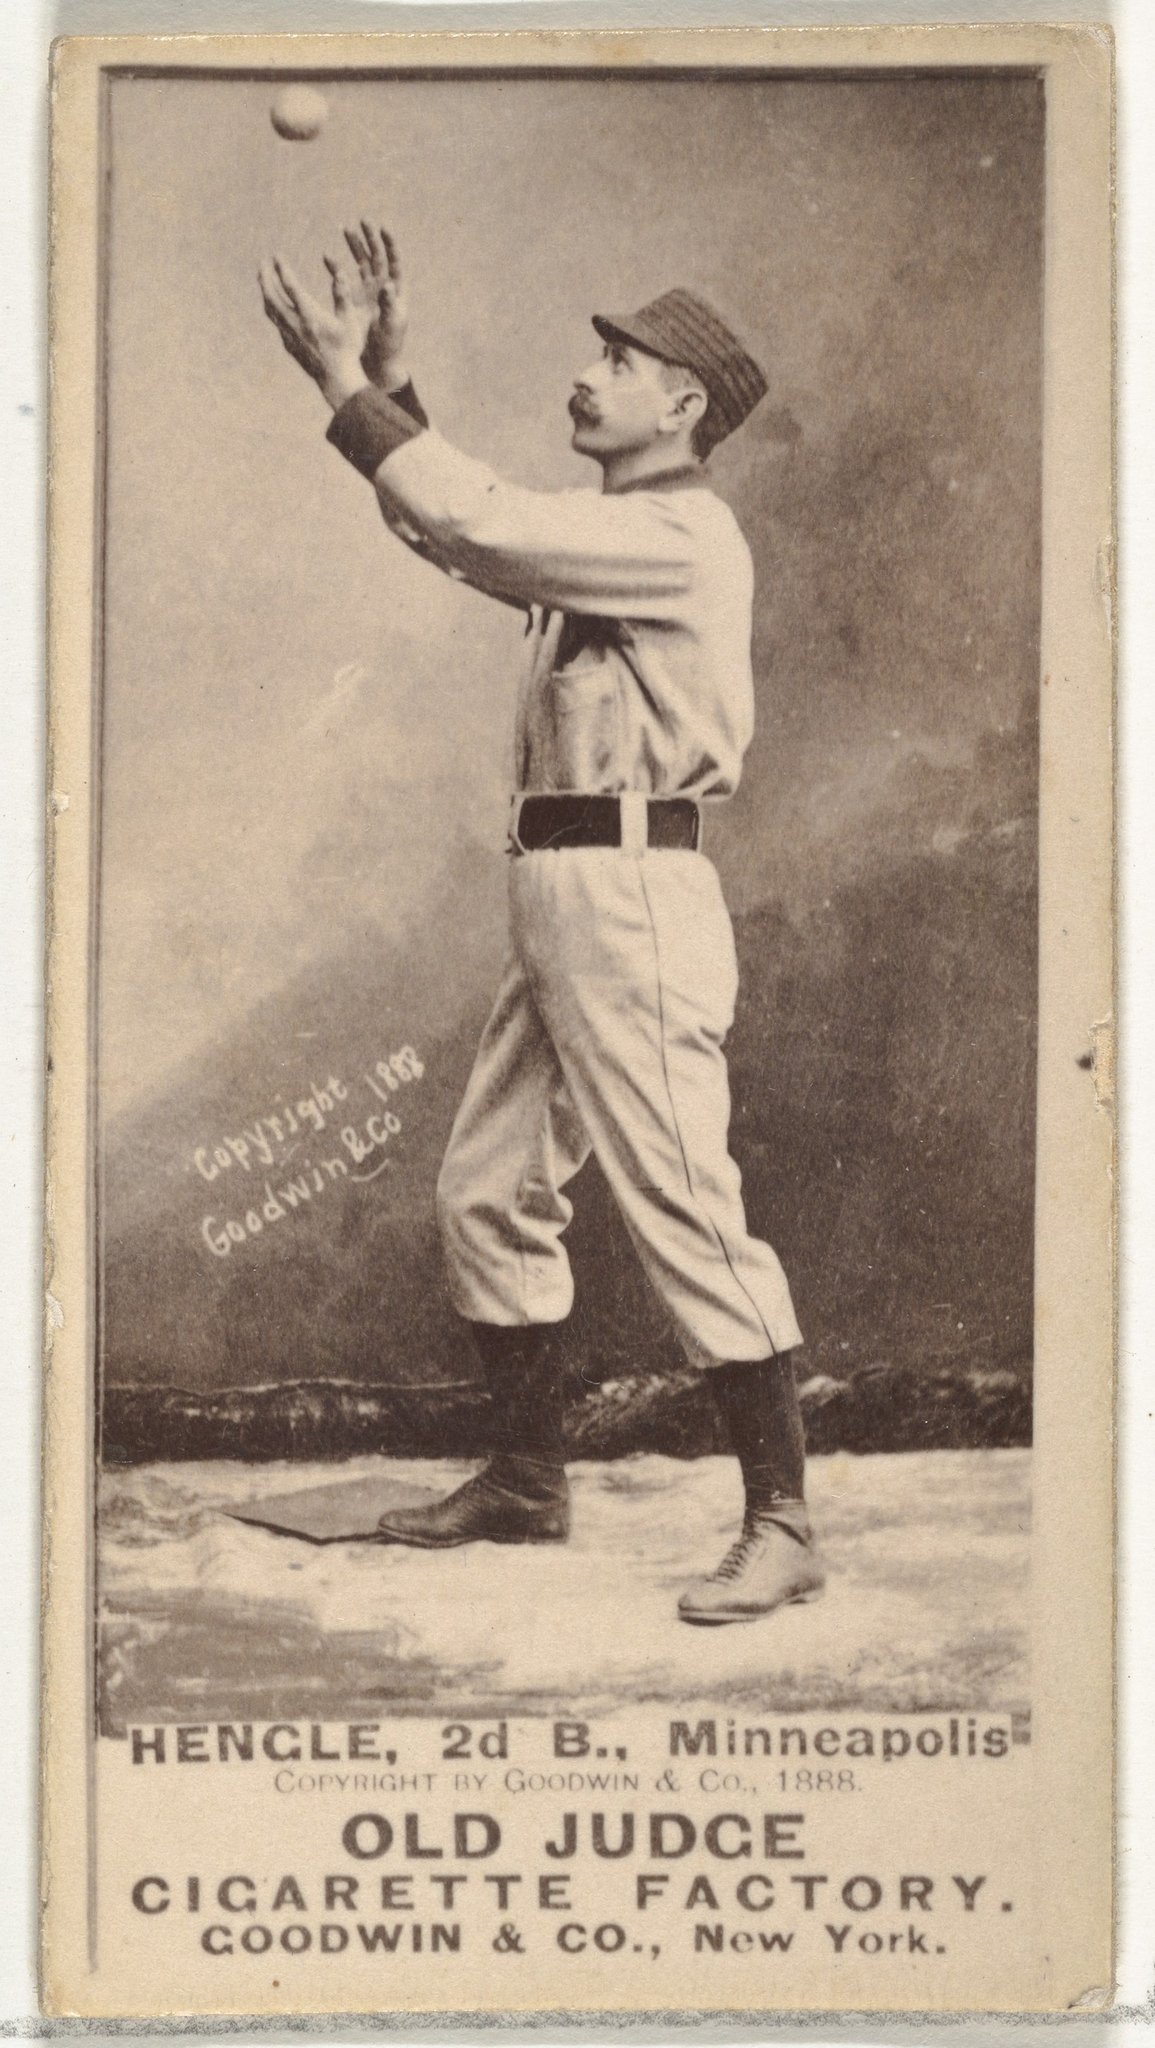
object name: baseball card, photograph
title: Emery J. "Moxie" Hengel, 2nd Base, Minneapolis, from the Old Judge series (N172) for Old Judge Cigarettes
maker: goodwin & company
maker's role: publisher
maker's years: 1850-1950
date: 1888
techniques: albumen silver print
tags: men,portraits,baseball,athletes